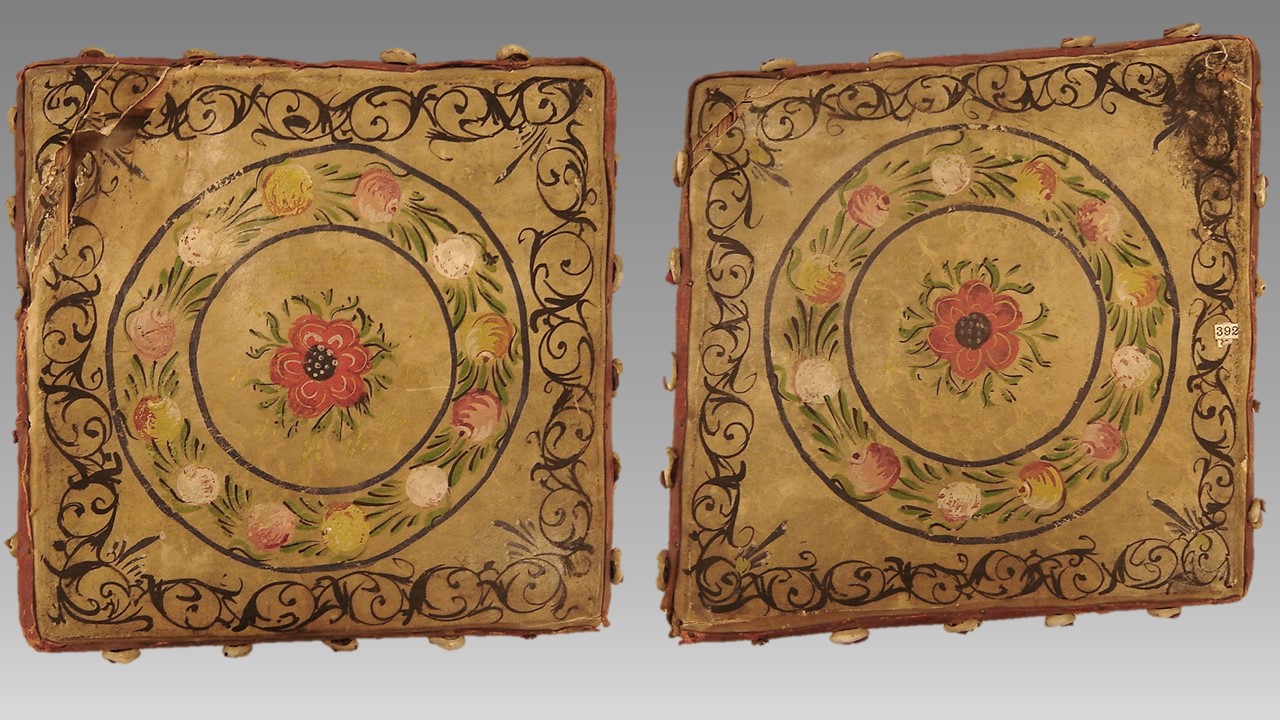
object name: daff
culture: arabian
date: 1867-1900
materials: parchment, wood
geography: arabia